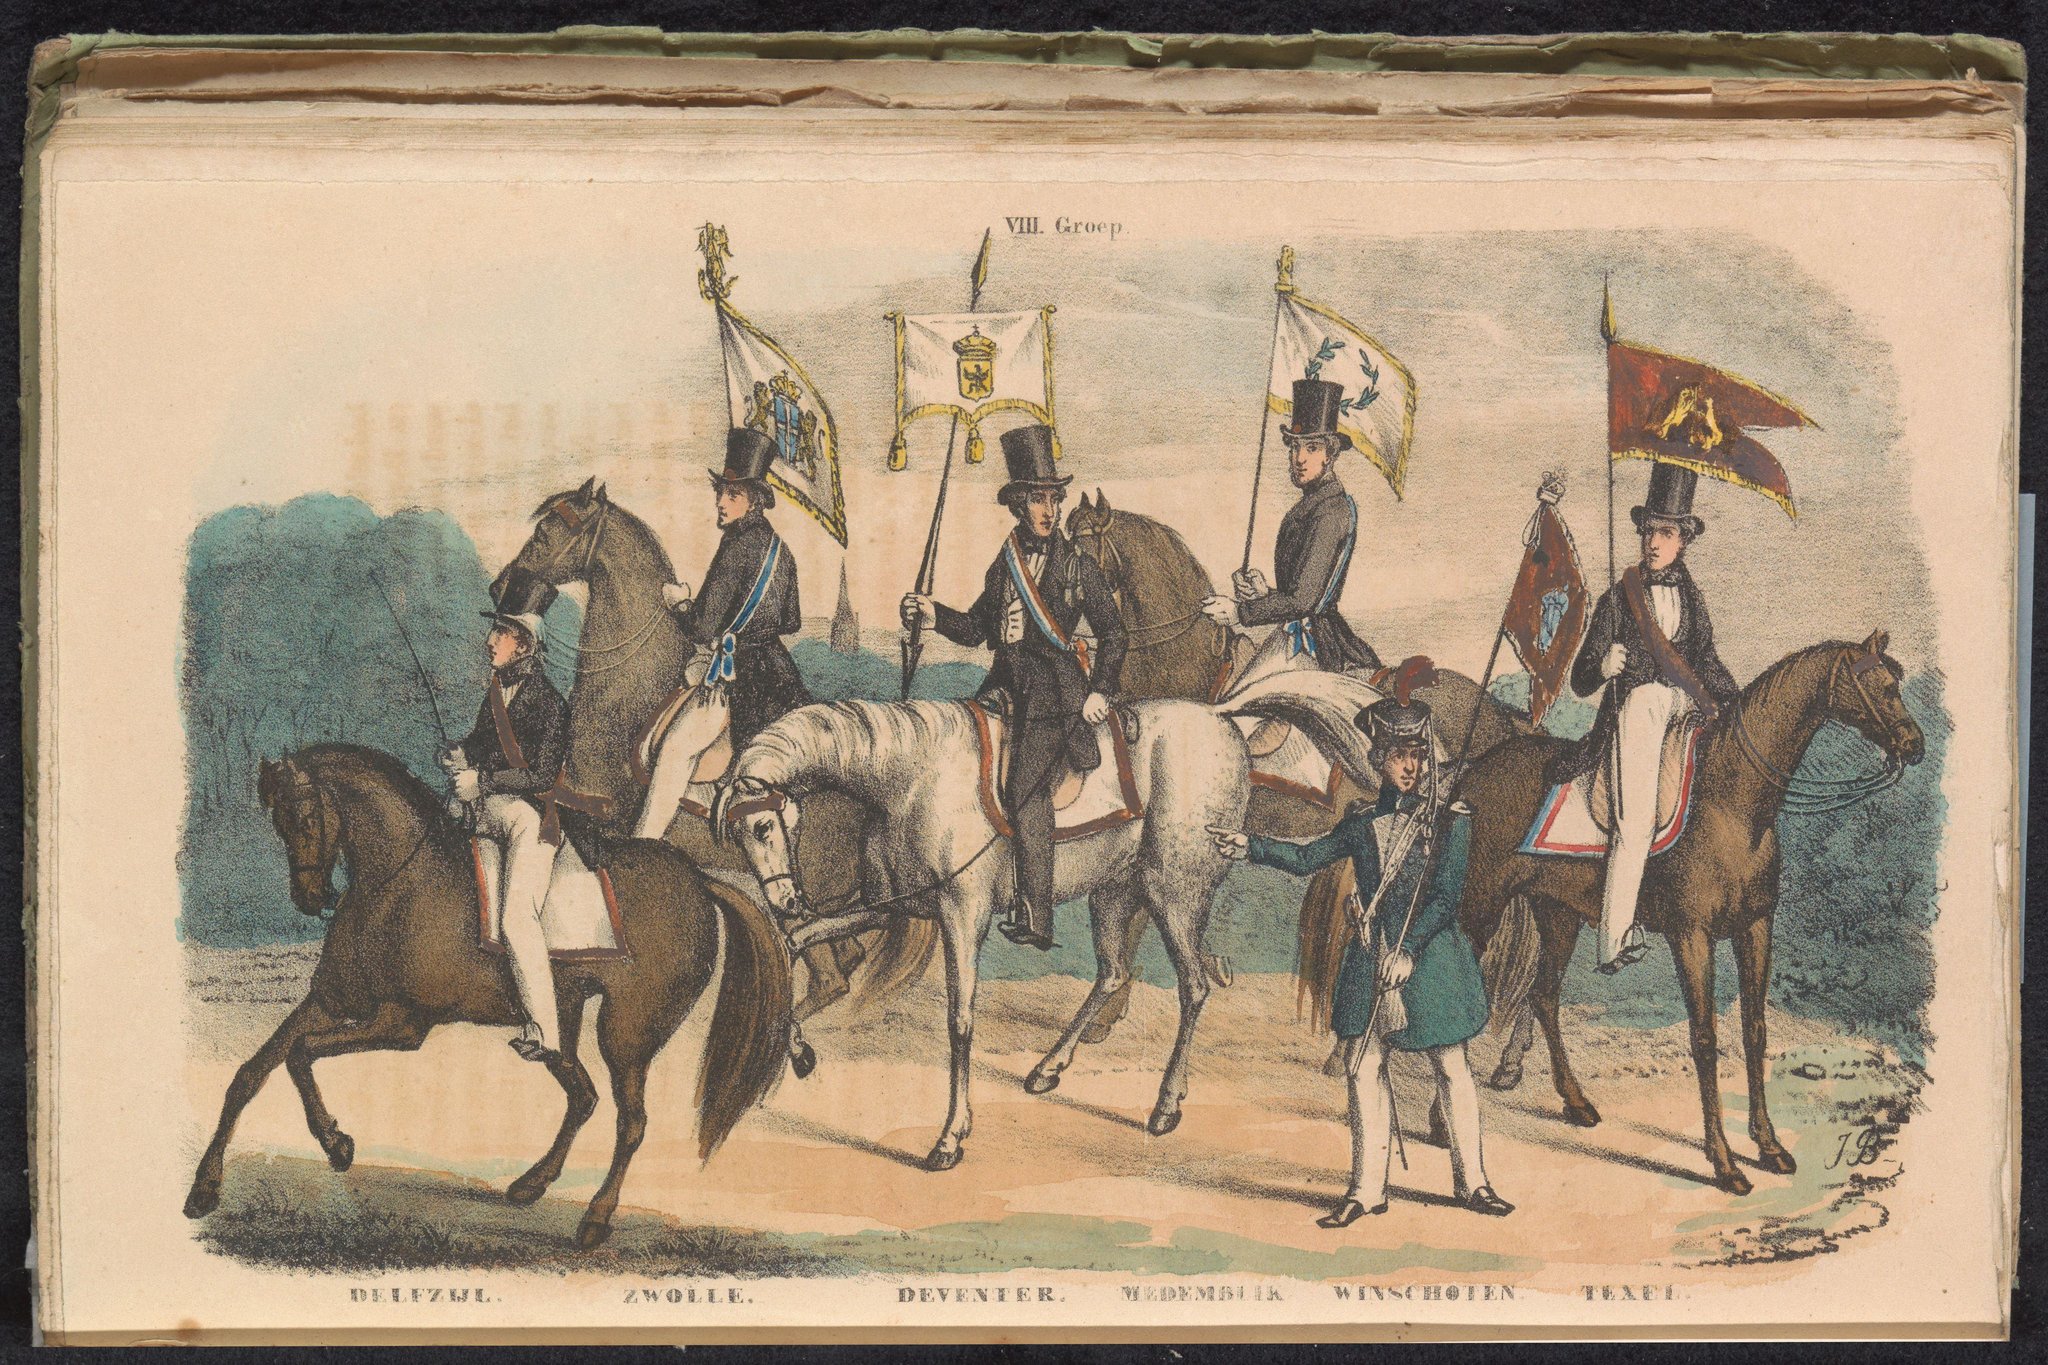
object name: book illustration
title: Kostumen en vaandels van de erewachten van Delfzijl, Zwolle, Deventer, Medemblik, Winschoten en Texel, 1840-1842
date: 1840-1842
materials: paper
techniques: hand coloring, lithograph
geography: den bosch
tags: william ii of the netherlands, clothes for official occasions, guard of honour, (military) uniforms, deventer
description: Kostumen en vaandels van de burger erewachten van Delfzijl, Zwolle, Deventer, Medemblik, Winschoten en Texel, 1840-1842. Vijf mannen te paard, vier met vaandels en een man te voet met vaandel. Illustratie in een boek met negen platen van de kleding gedragen door de burgererewachten tijdens het bezoek van koning Willem II aan die stad na zijn inhuldiging in 1840.